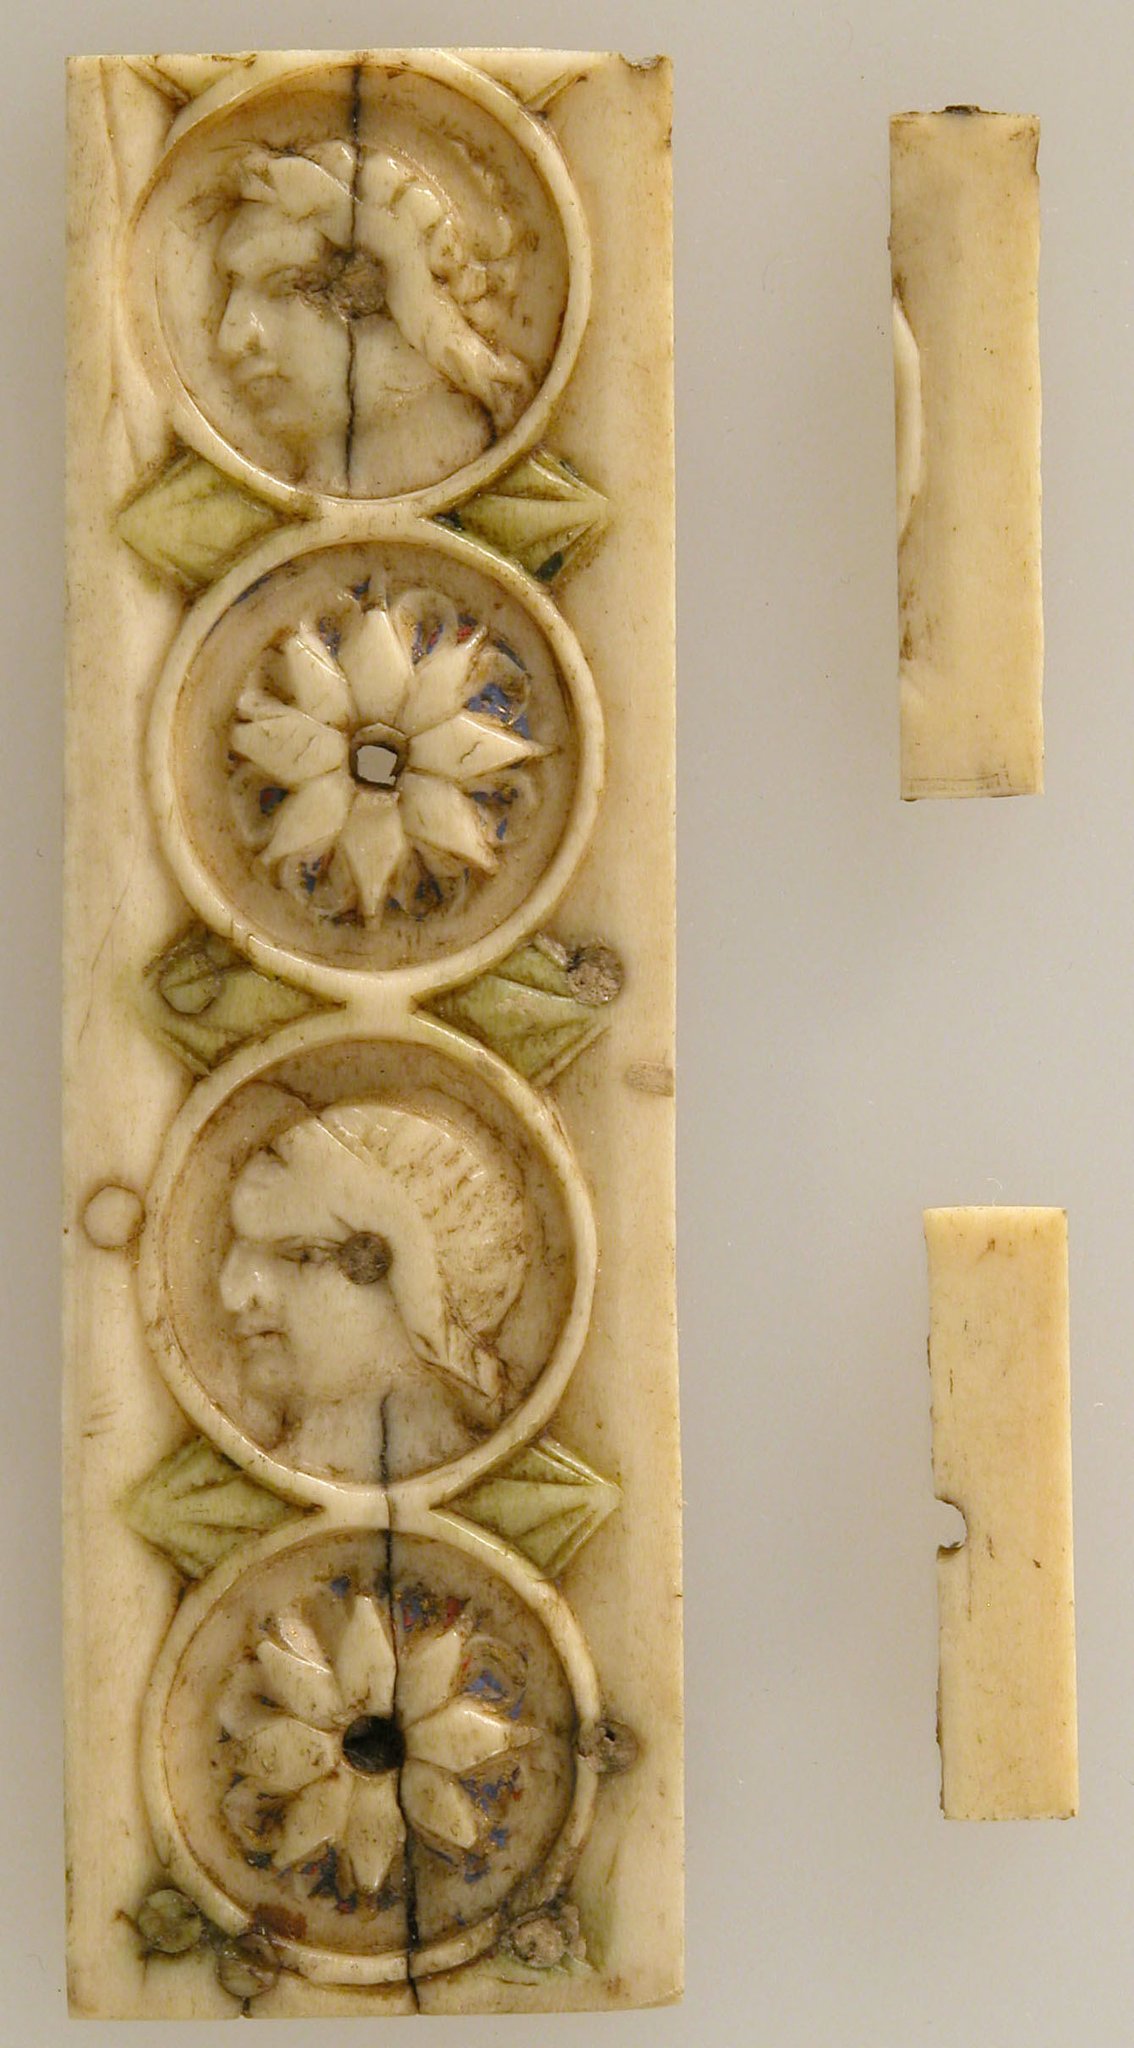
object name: casket fragment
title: Casket Fragments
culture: byzantine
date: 900-1000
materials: bone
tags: faces,profiles,flowers